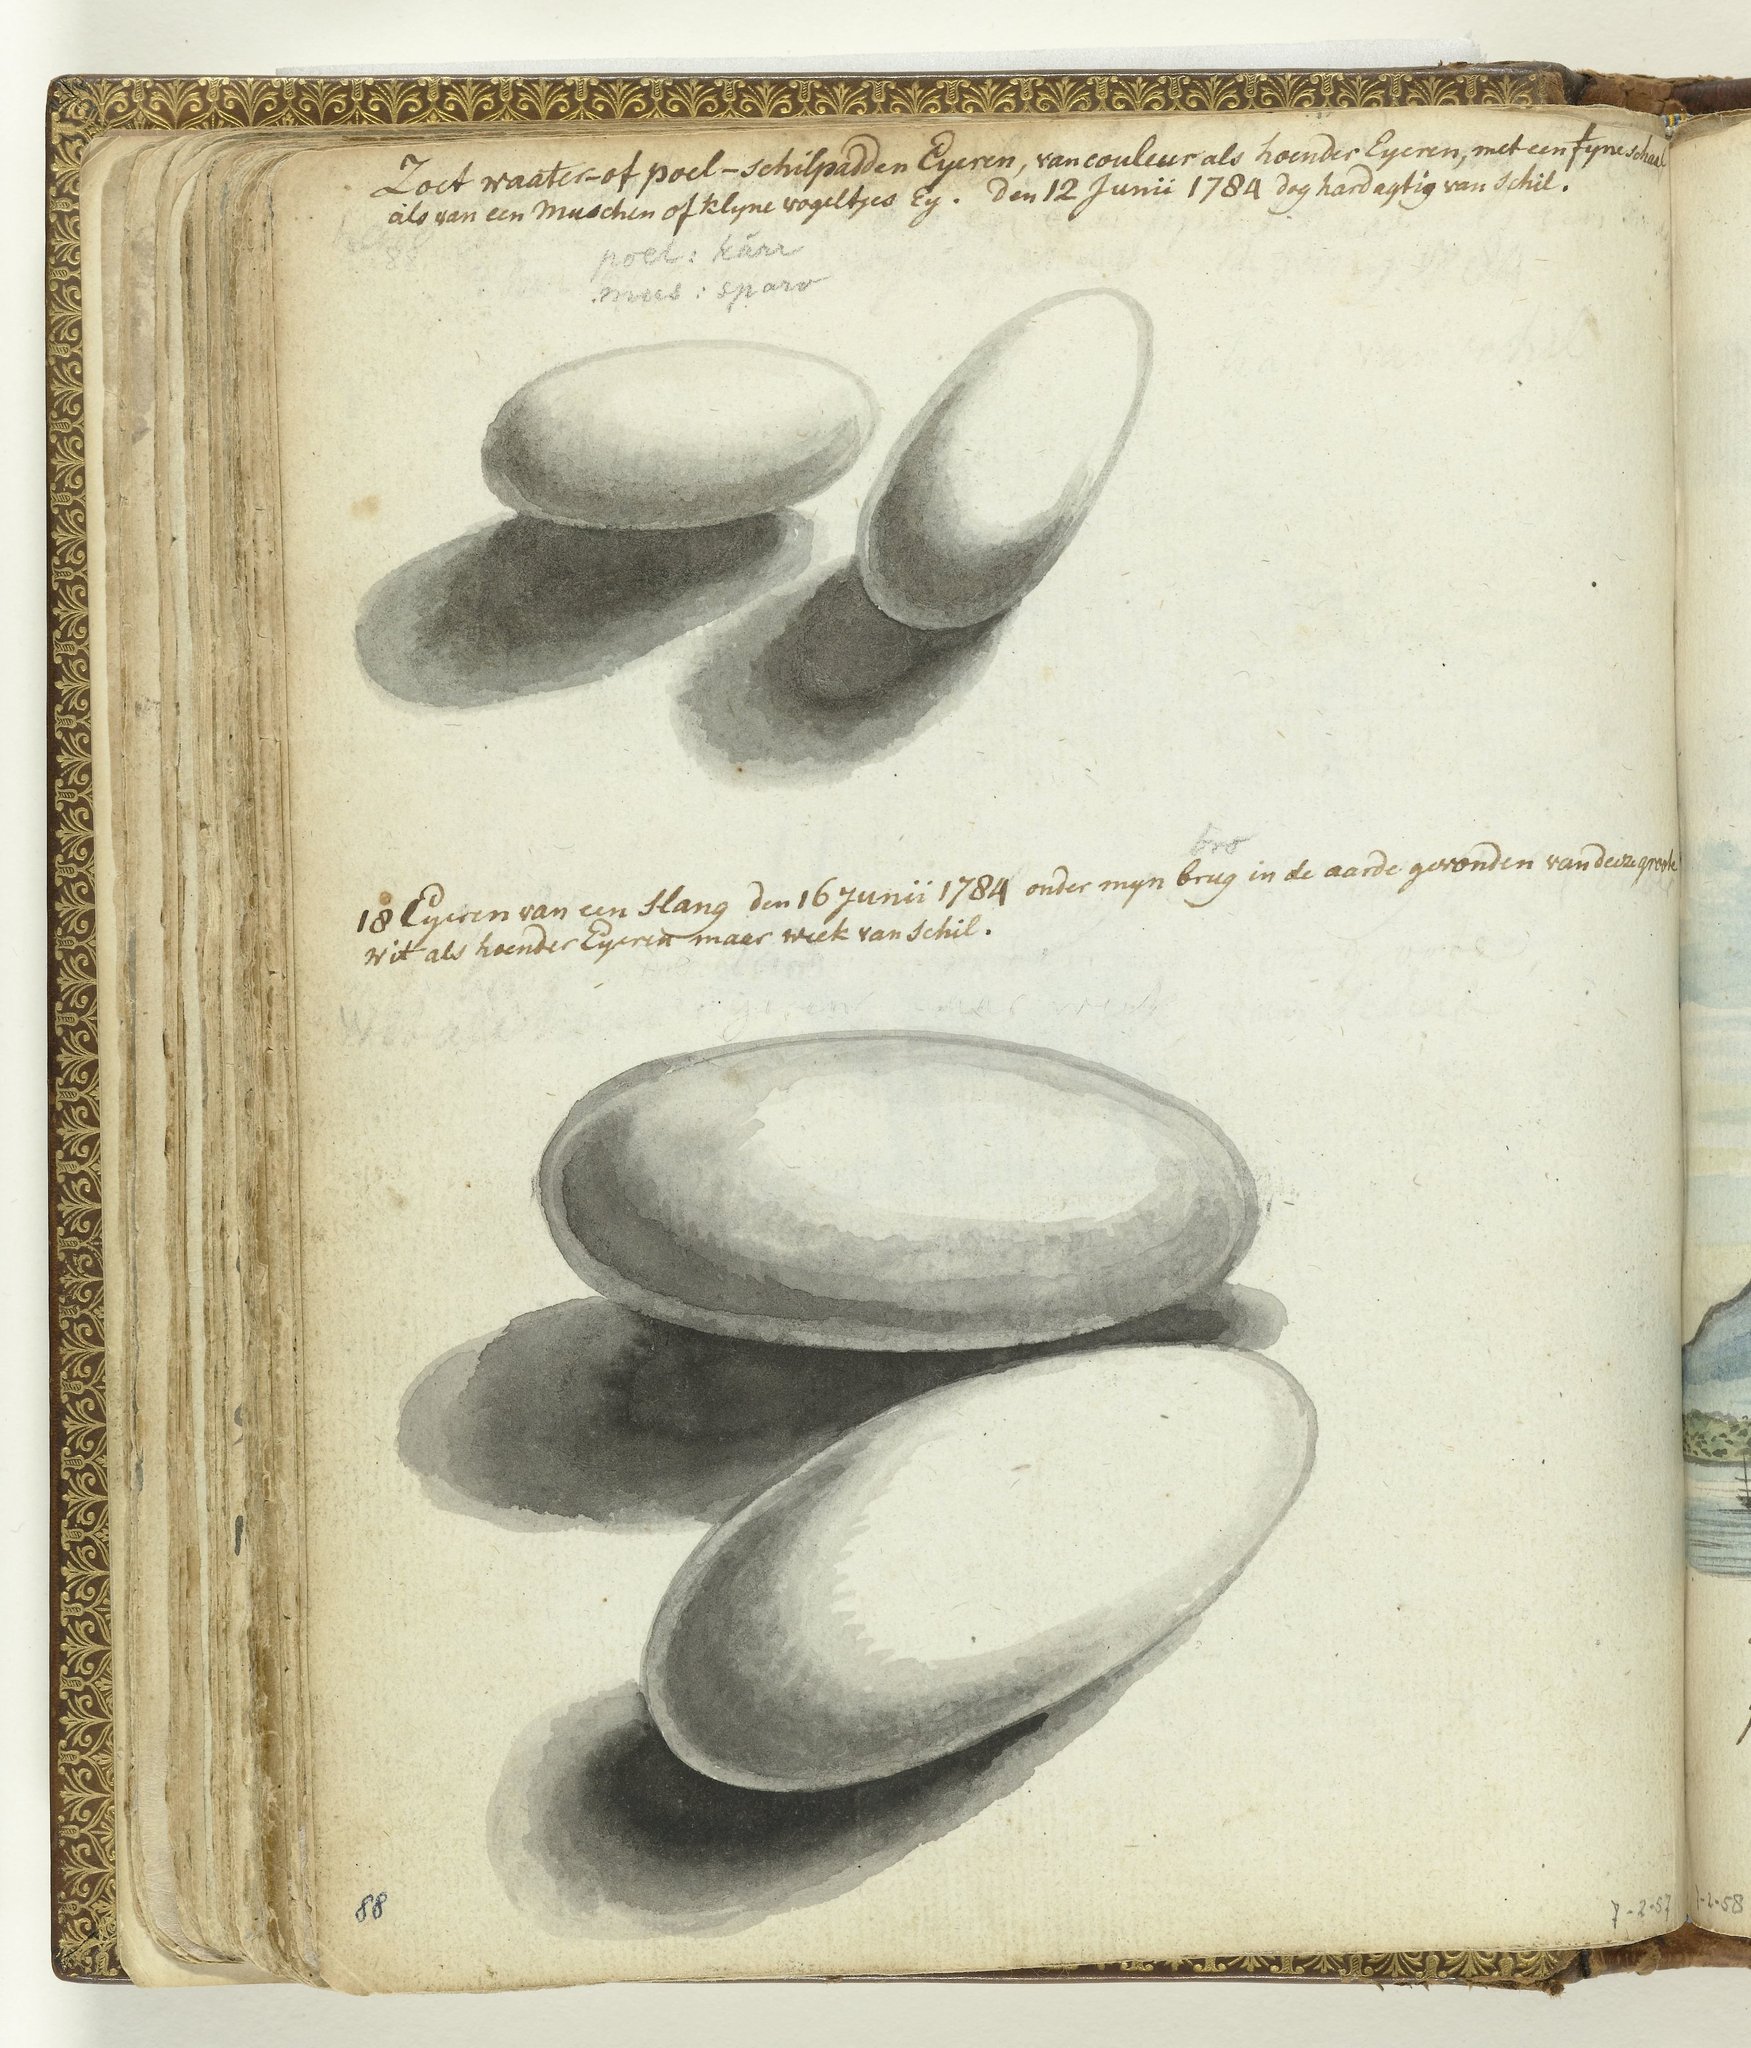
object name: drawing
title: Schildpad- en slangeneieren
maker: jan brandes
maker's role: draughtsman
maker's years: 1743-1808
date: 1784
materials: ink, paper, pencil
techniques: brush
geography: jakarta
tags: tortoises, turtles (+ egg), snakes (+ egg)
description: Zwartwit tekening van twee soorten eieren. Met opschrift. Onderdeel uit het schetsboek van Jan Brandes, dl. 2 (1808), p. 88.